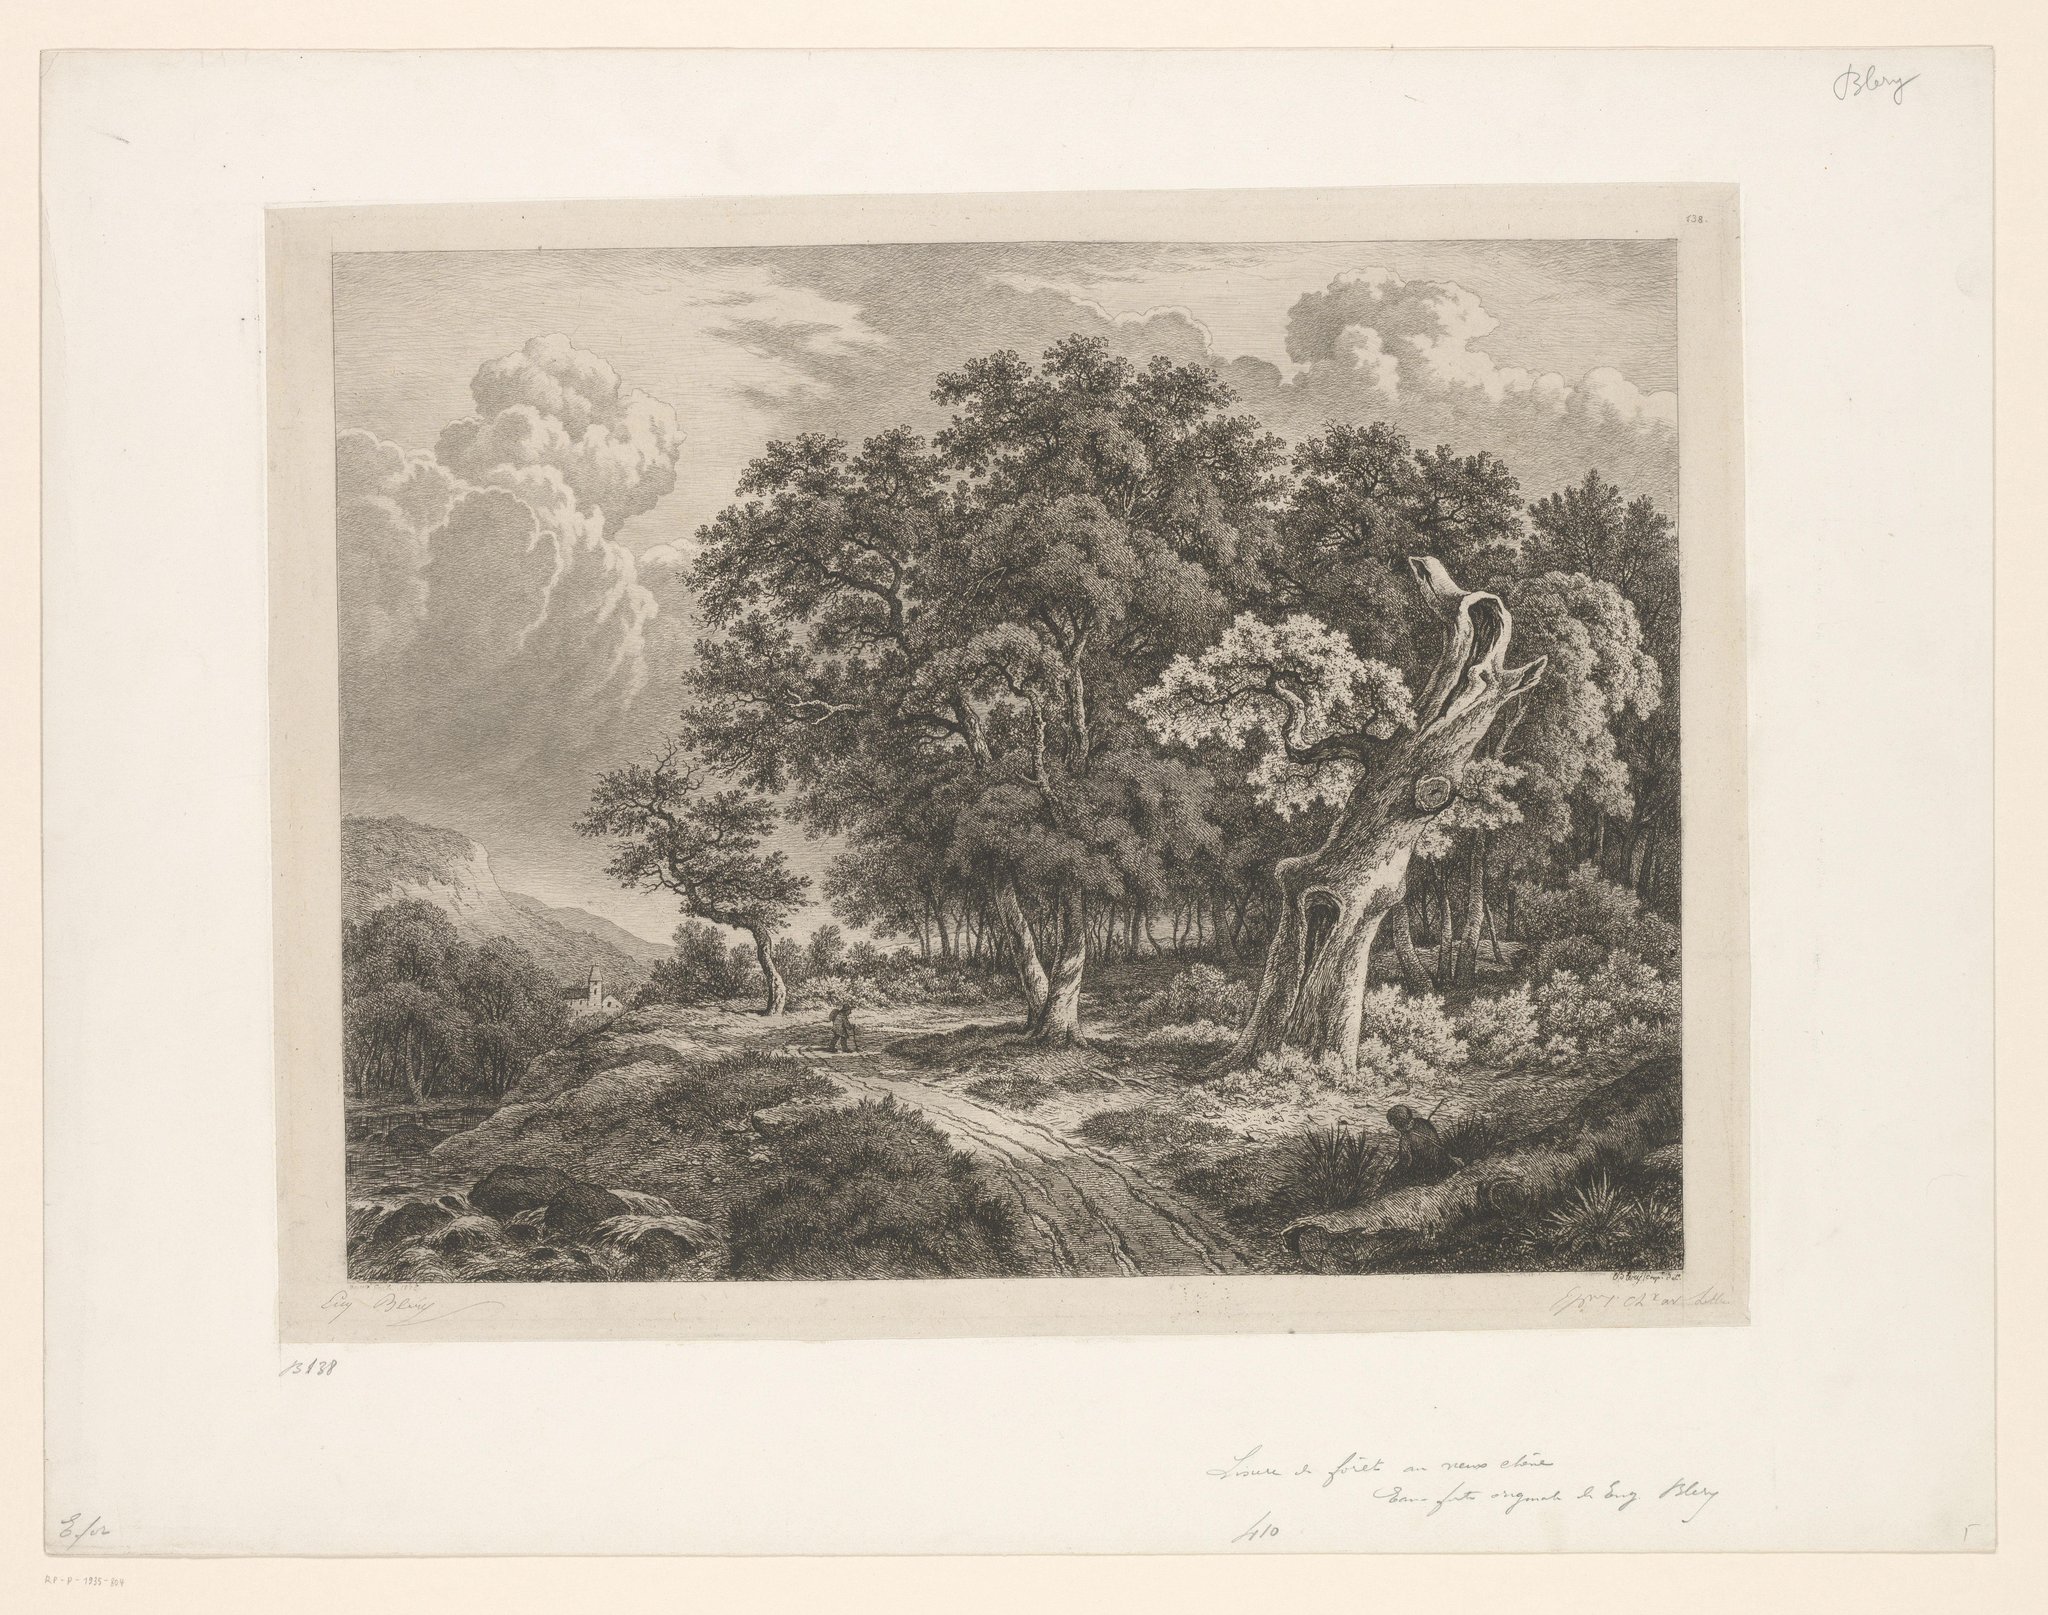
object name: print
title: La lisière de forêt au vieux chêne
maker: eugène bléry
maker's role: print maker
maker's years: 1805-1887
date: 1876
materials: paper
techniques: engraving, etching, roulette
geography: france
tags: water course, forest path or lane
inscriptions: collector's mark: Lugt 2228